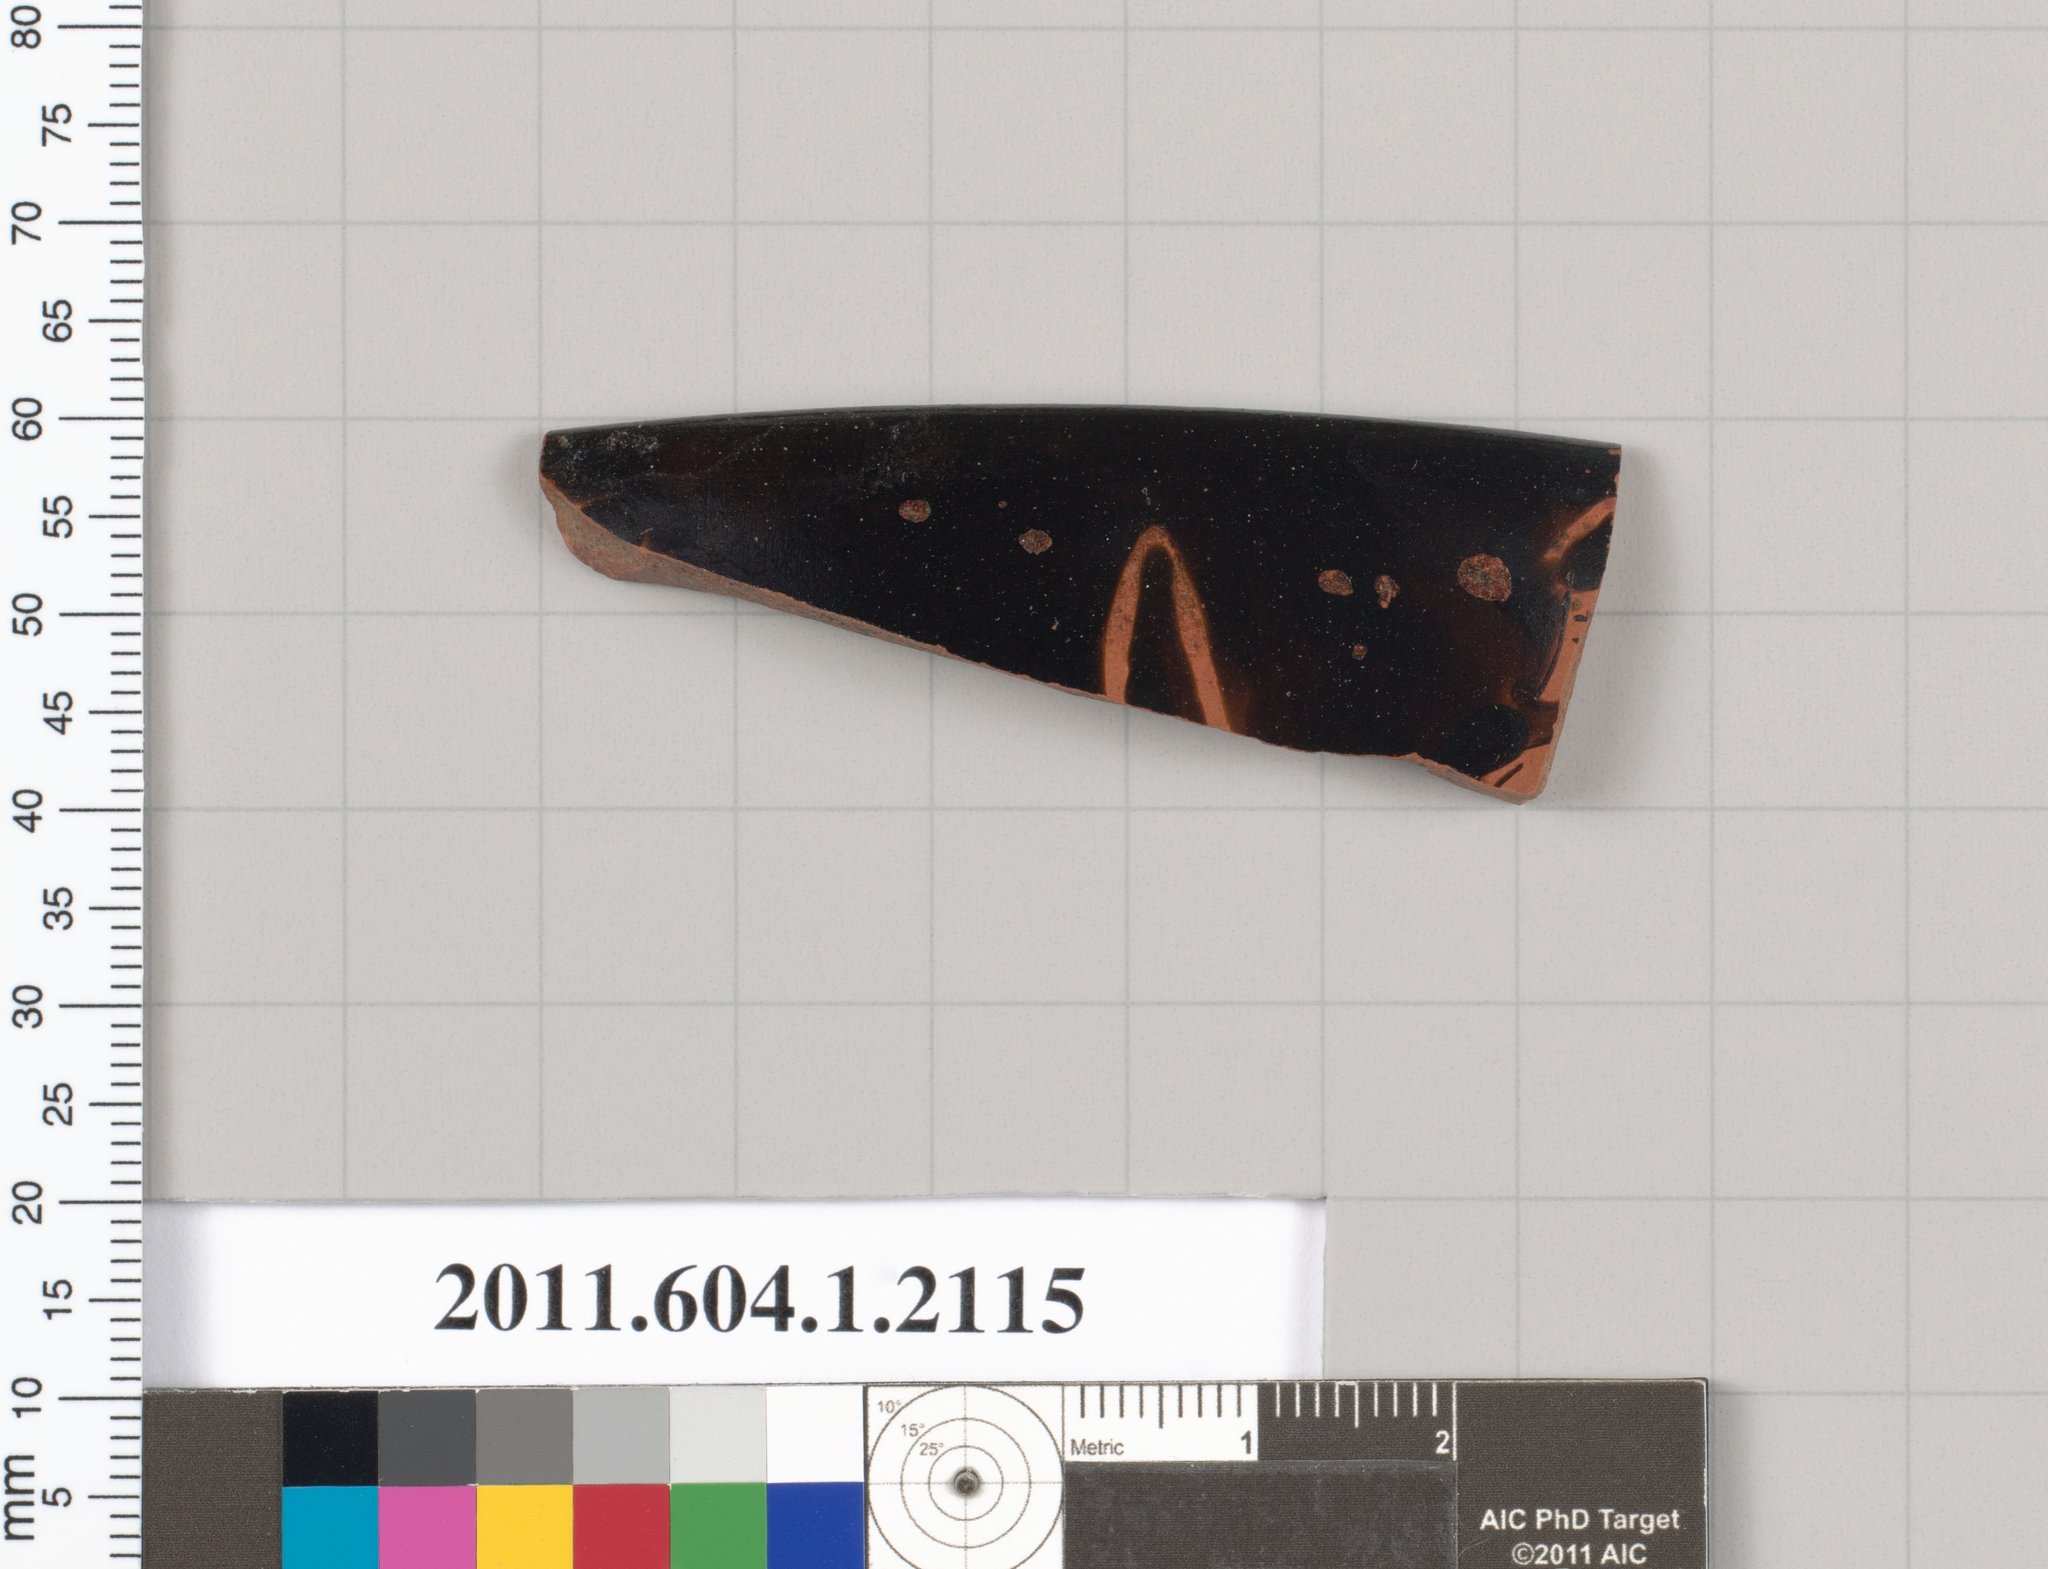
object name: kylix fragment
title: Terracotta rim fragment of a kylix (drinking cup)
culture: greek, attic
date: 475-451 BCE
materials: terracotta